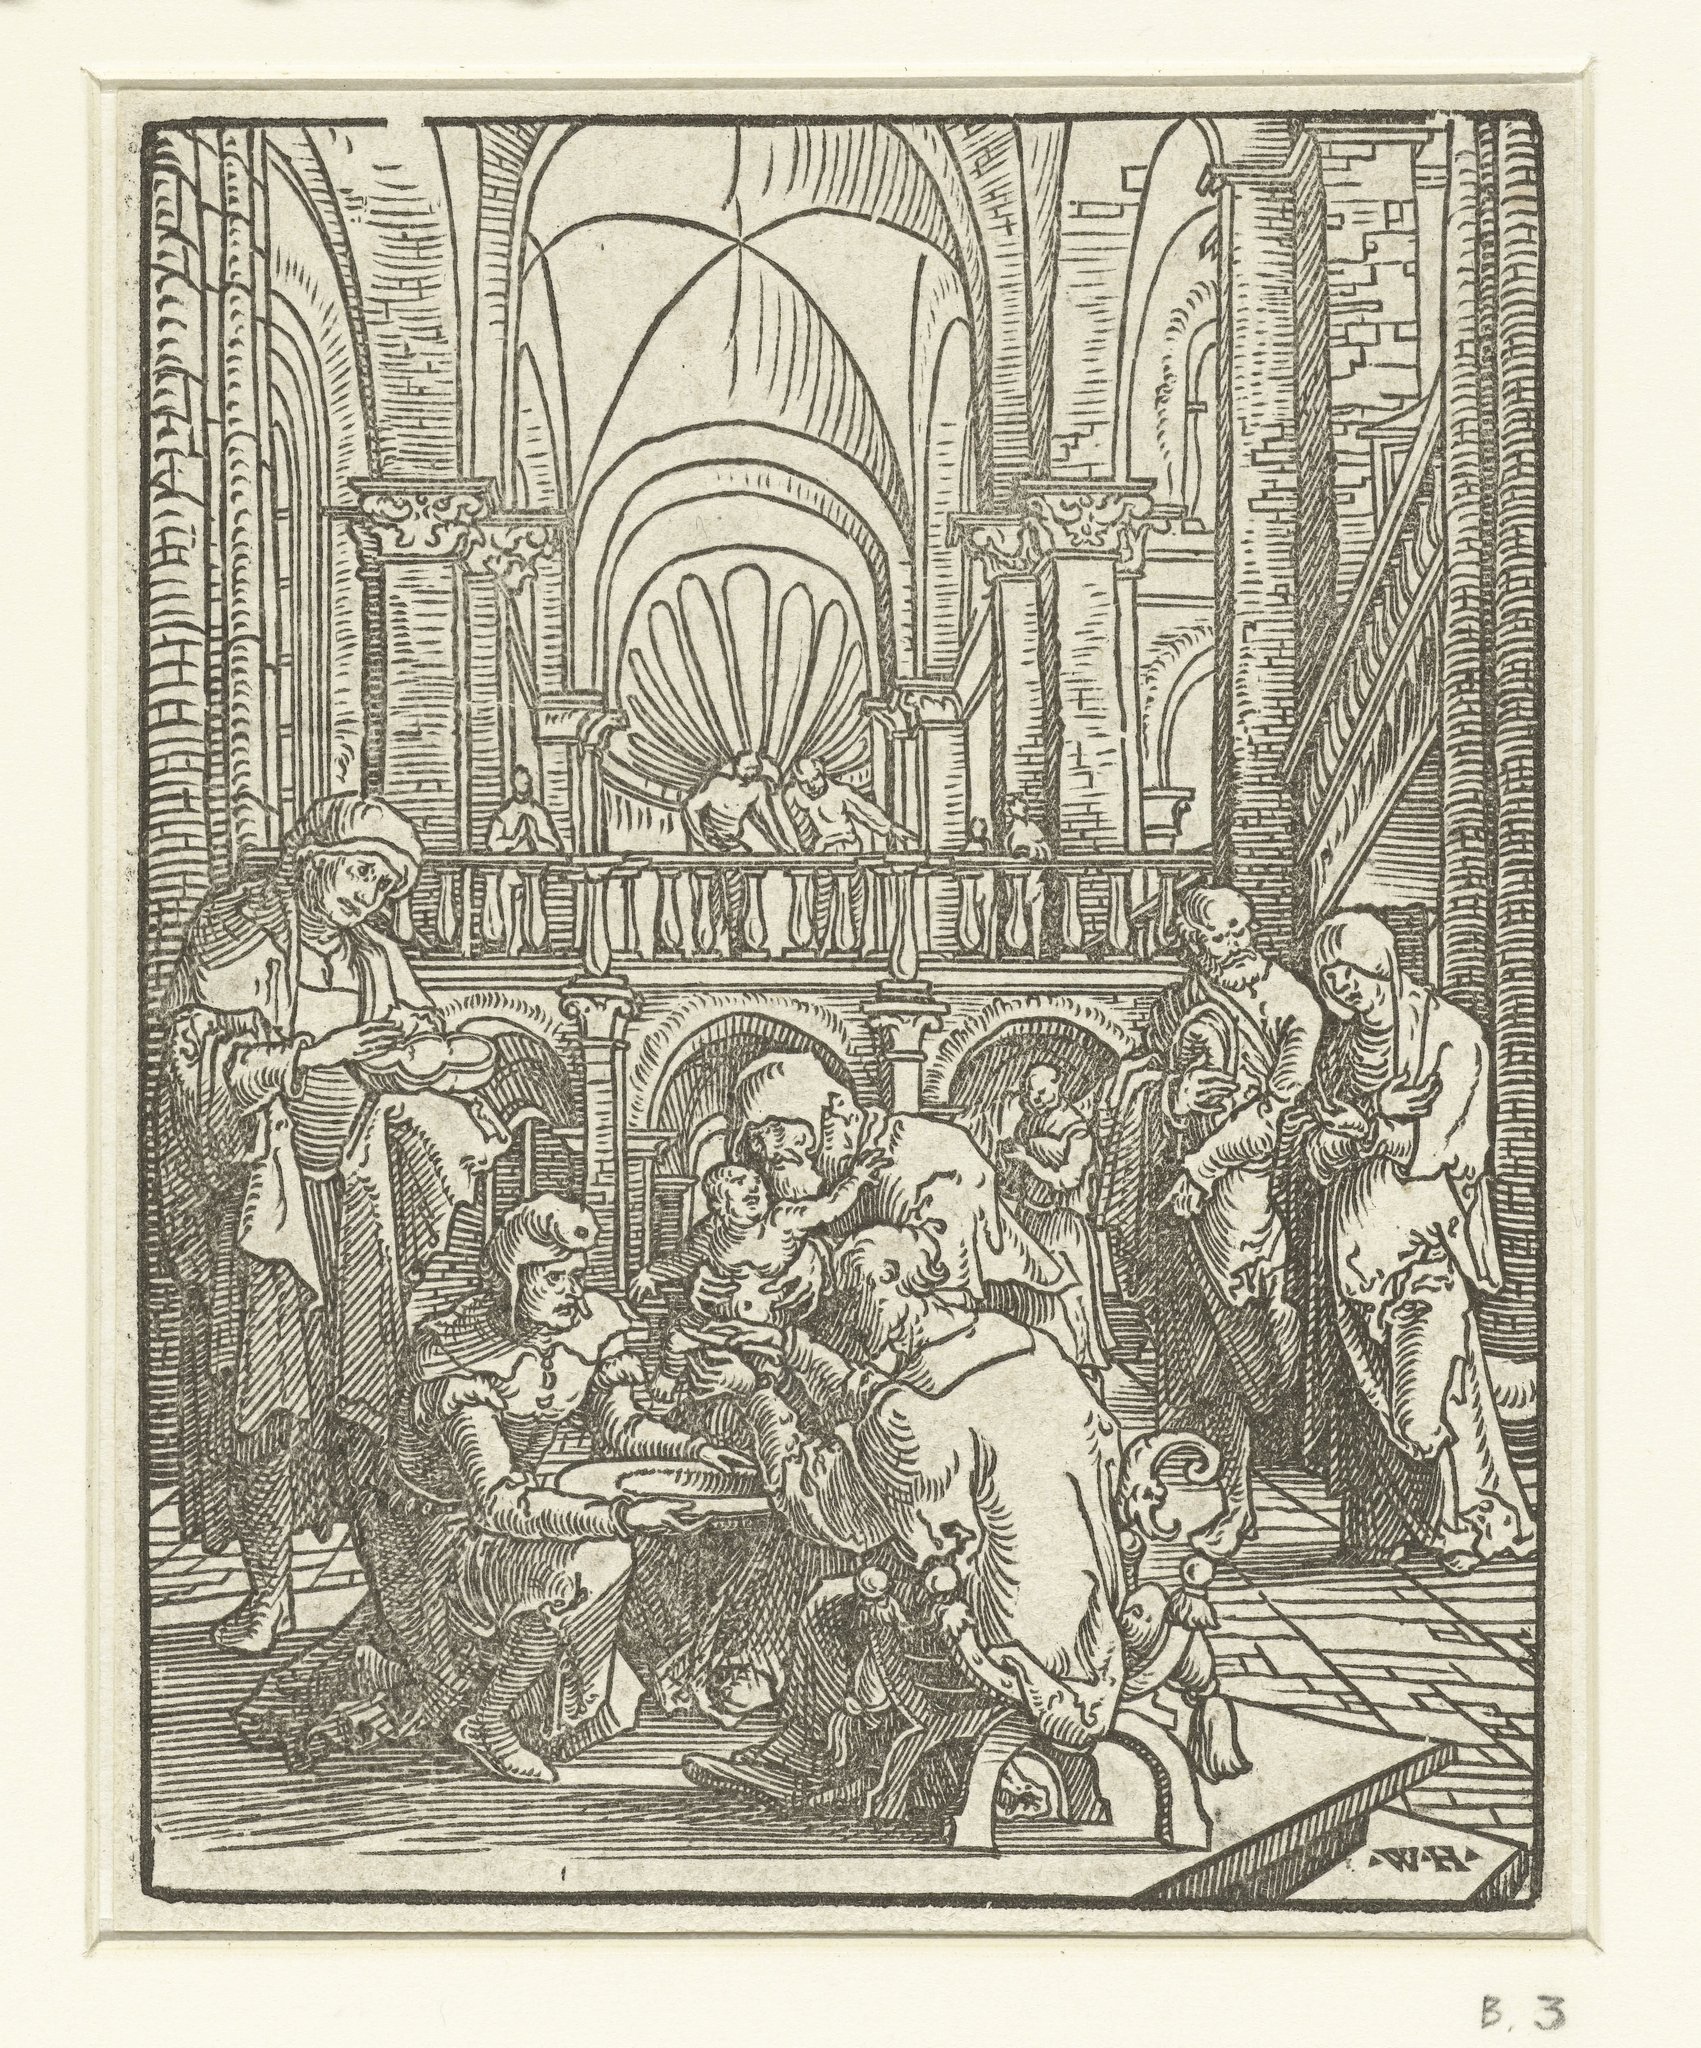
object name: print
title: Besnijdenis van Christus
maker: wolfgang huber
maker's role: draughtsman, print maker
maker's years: 1490-1553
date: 1500-1537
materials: paper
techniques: woodcut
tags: circumcision of the christ-child by the priest in the temple (luke 2:21)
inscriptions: collector's mark: Lugt 2228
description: Een man houdt het Christuskind vast terwijl de priester met een mes de besnijdenis verricht. Een man knielt met een schaal bij hen. Rechts op de achtergrond staan Jozef en Maria. De gebeurtenis vindt plaats in het interieur van een kerk.